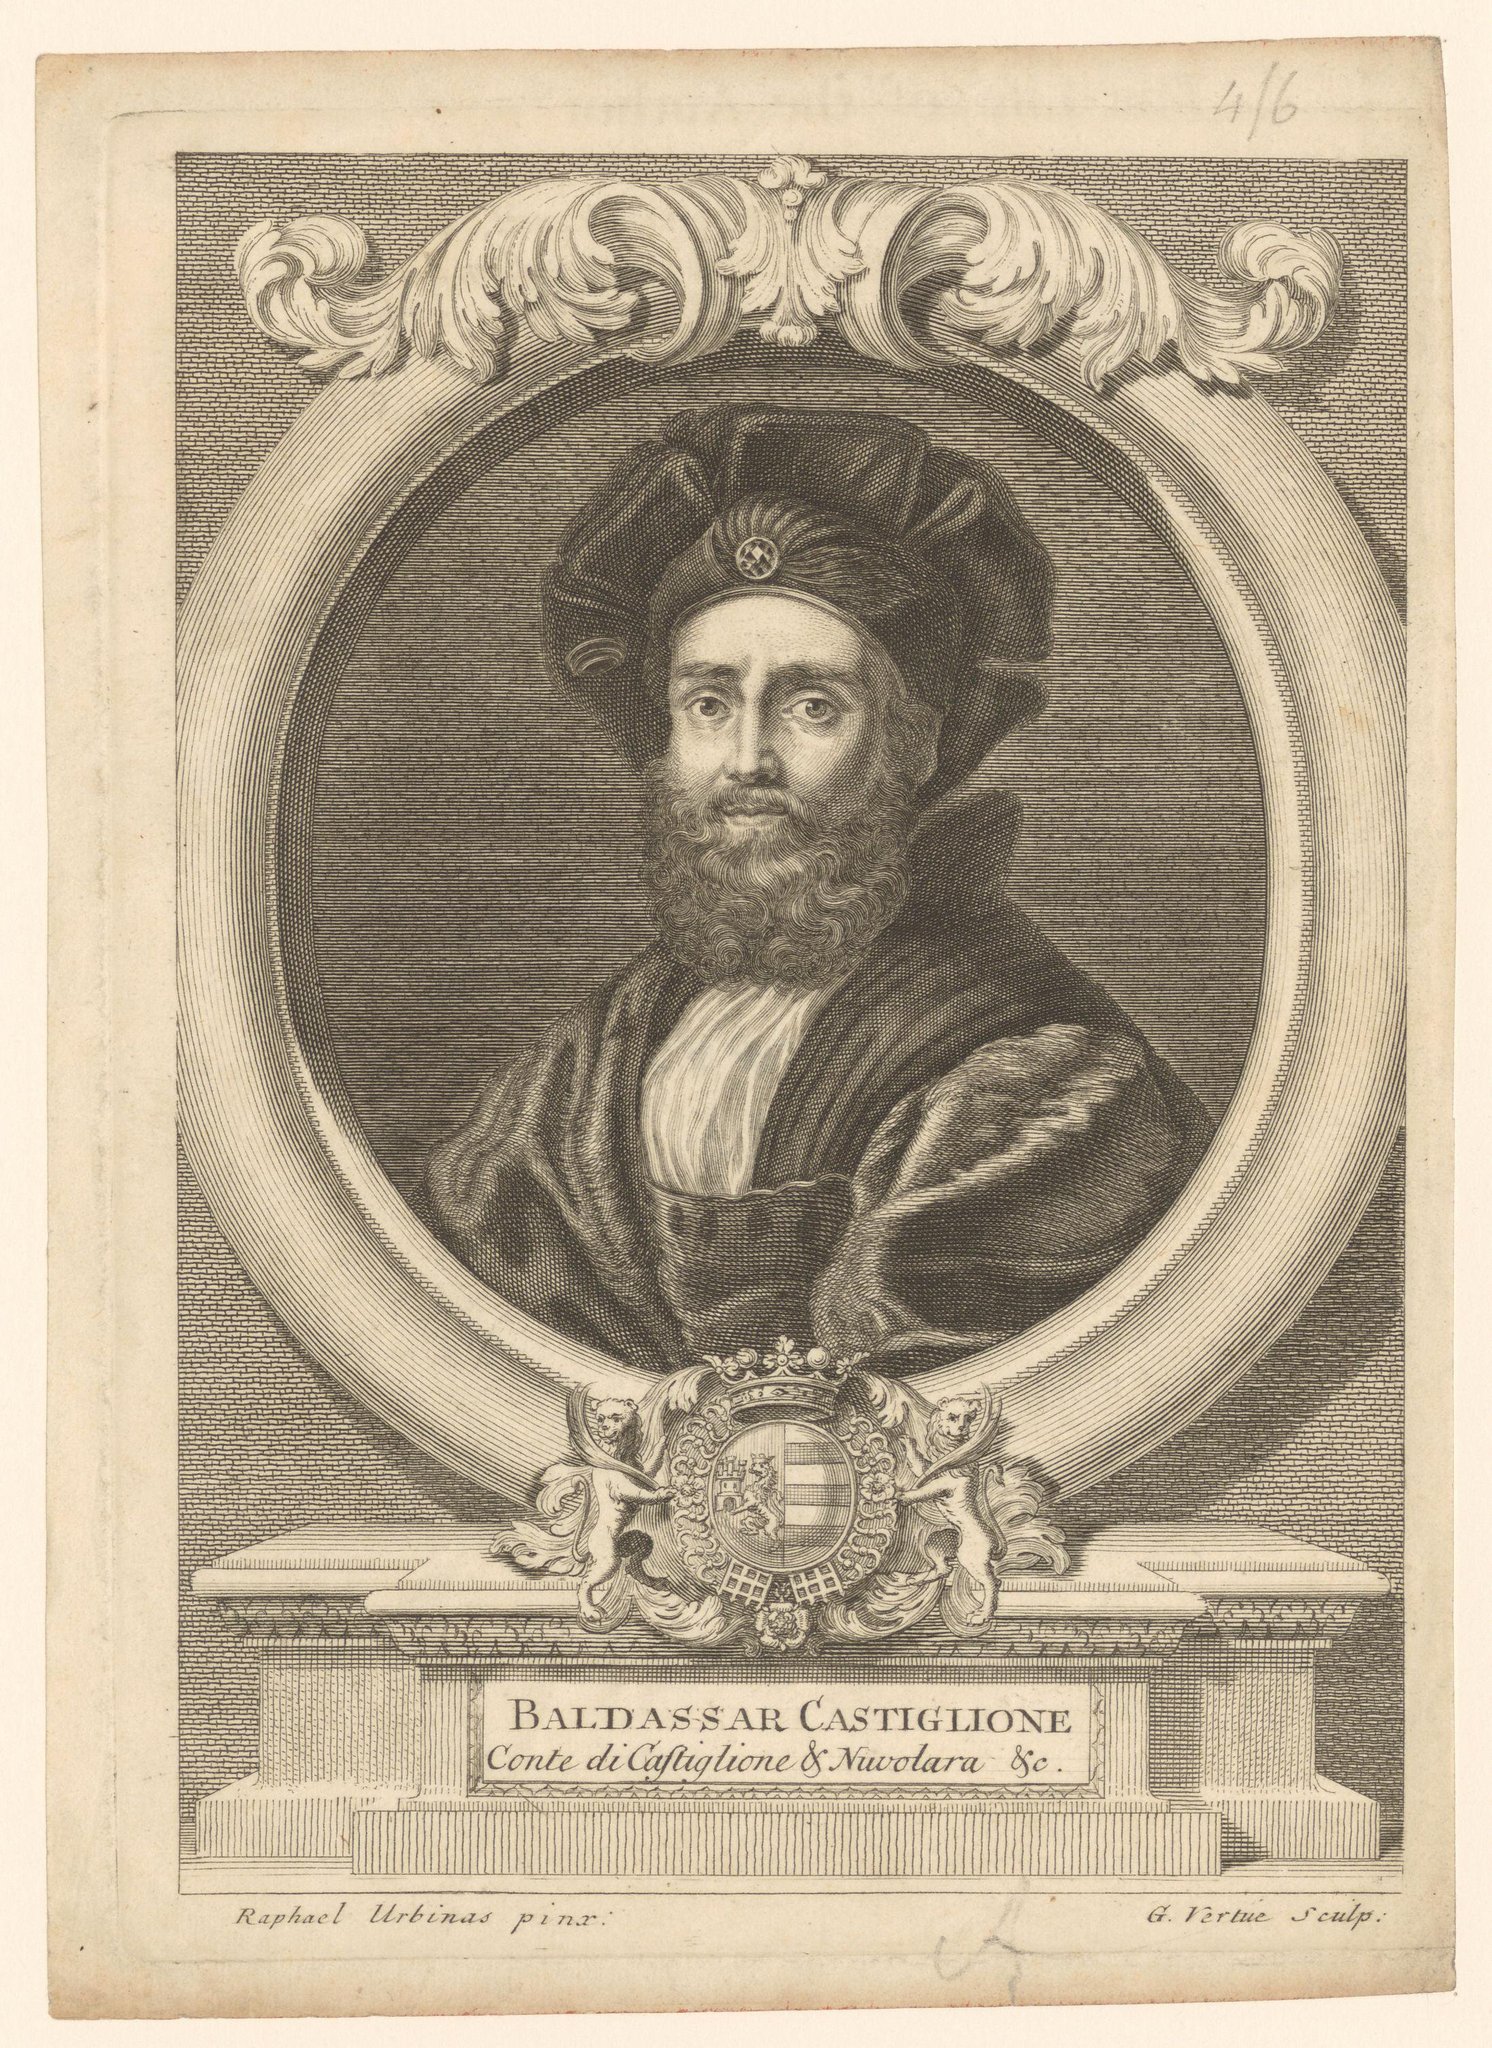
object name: print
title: Portret van Baldassare Castiglione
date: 1694-1756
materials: paper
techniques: engraving, etching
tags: historical persons, politician, e.g. party leader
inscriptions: collector's mark: Lugt 2228